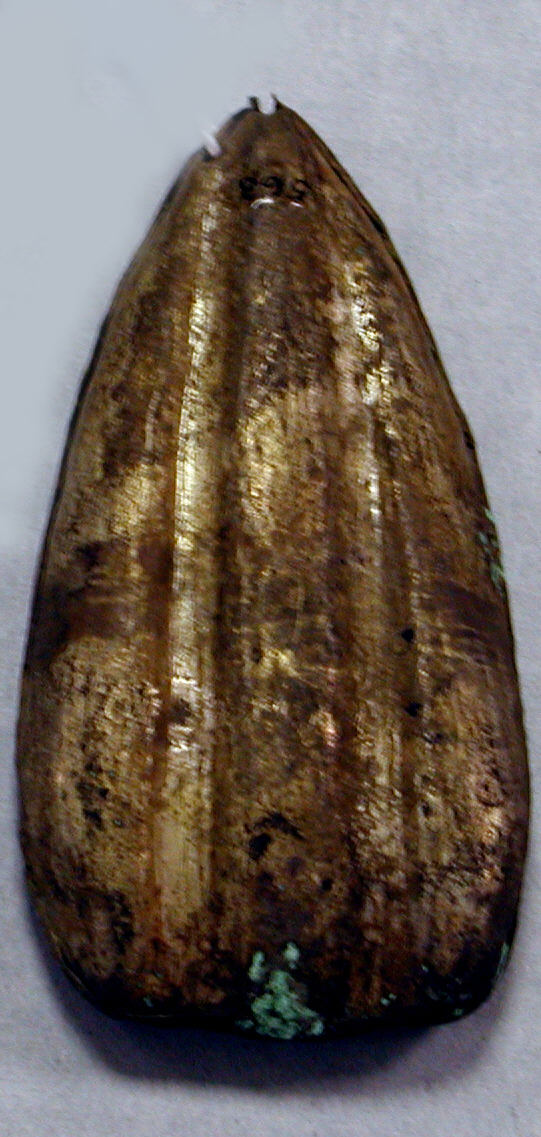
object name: ornament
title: Hammered Silver Petal Ornament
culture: peruvian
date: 701-1566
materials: gilt, silver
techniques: hammering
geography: peru